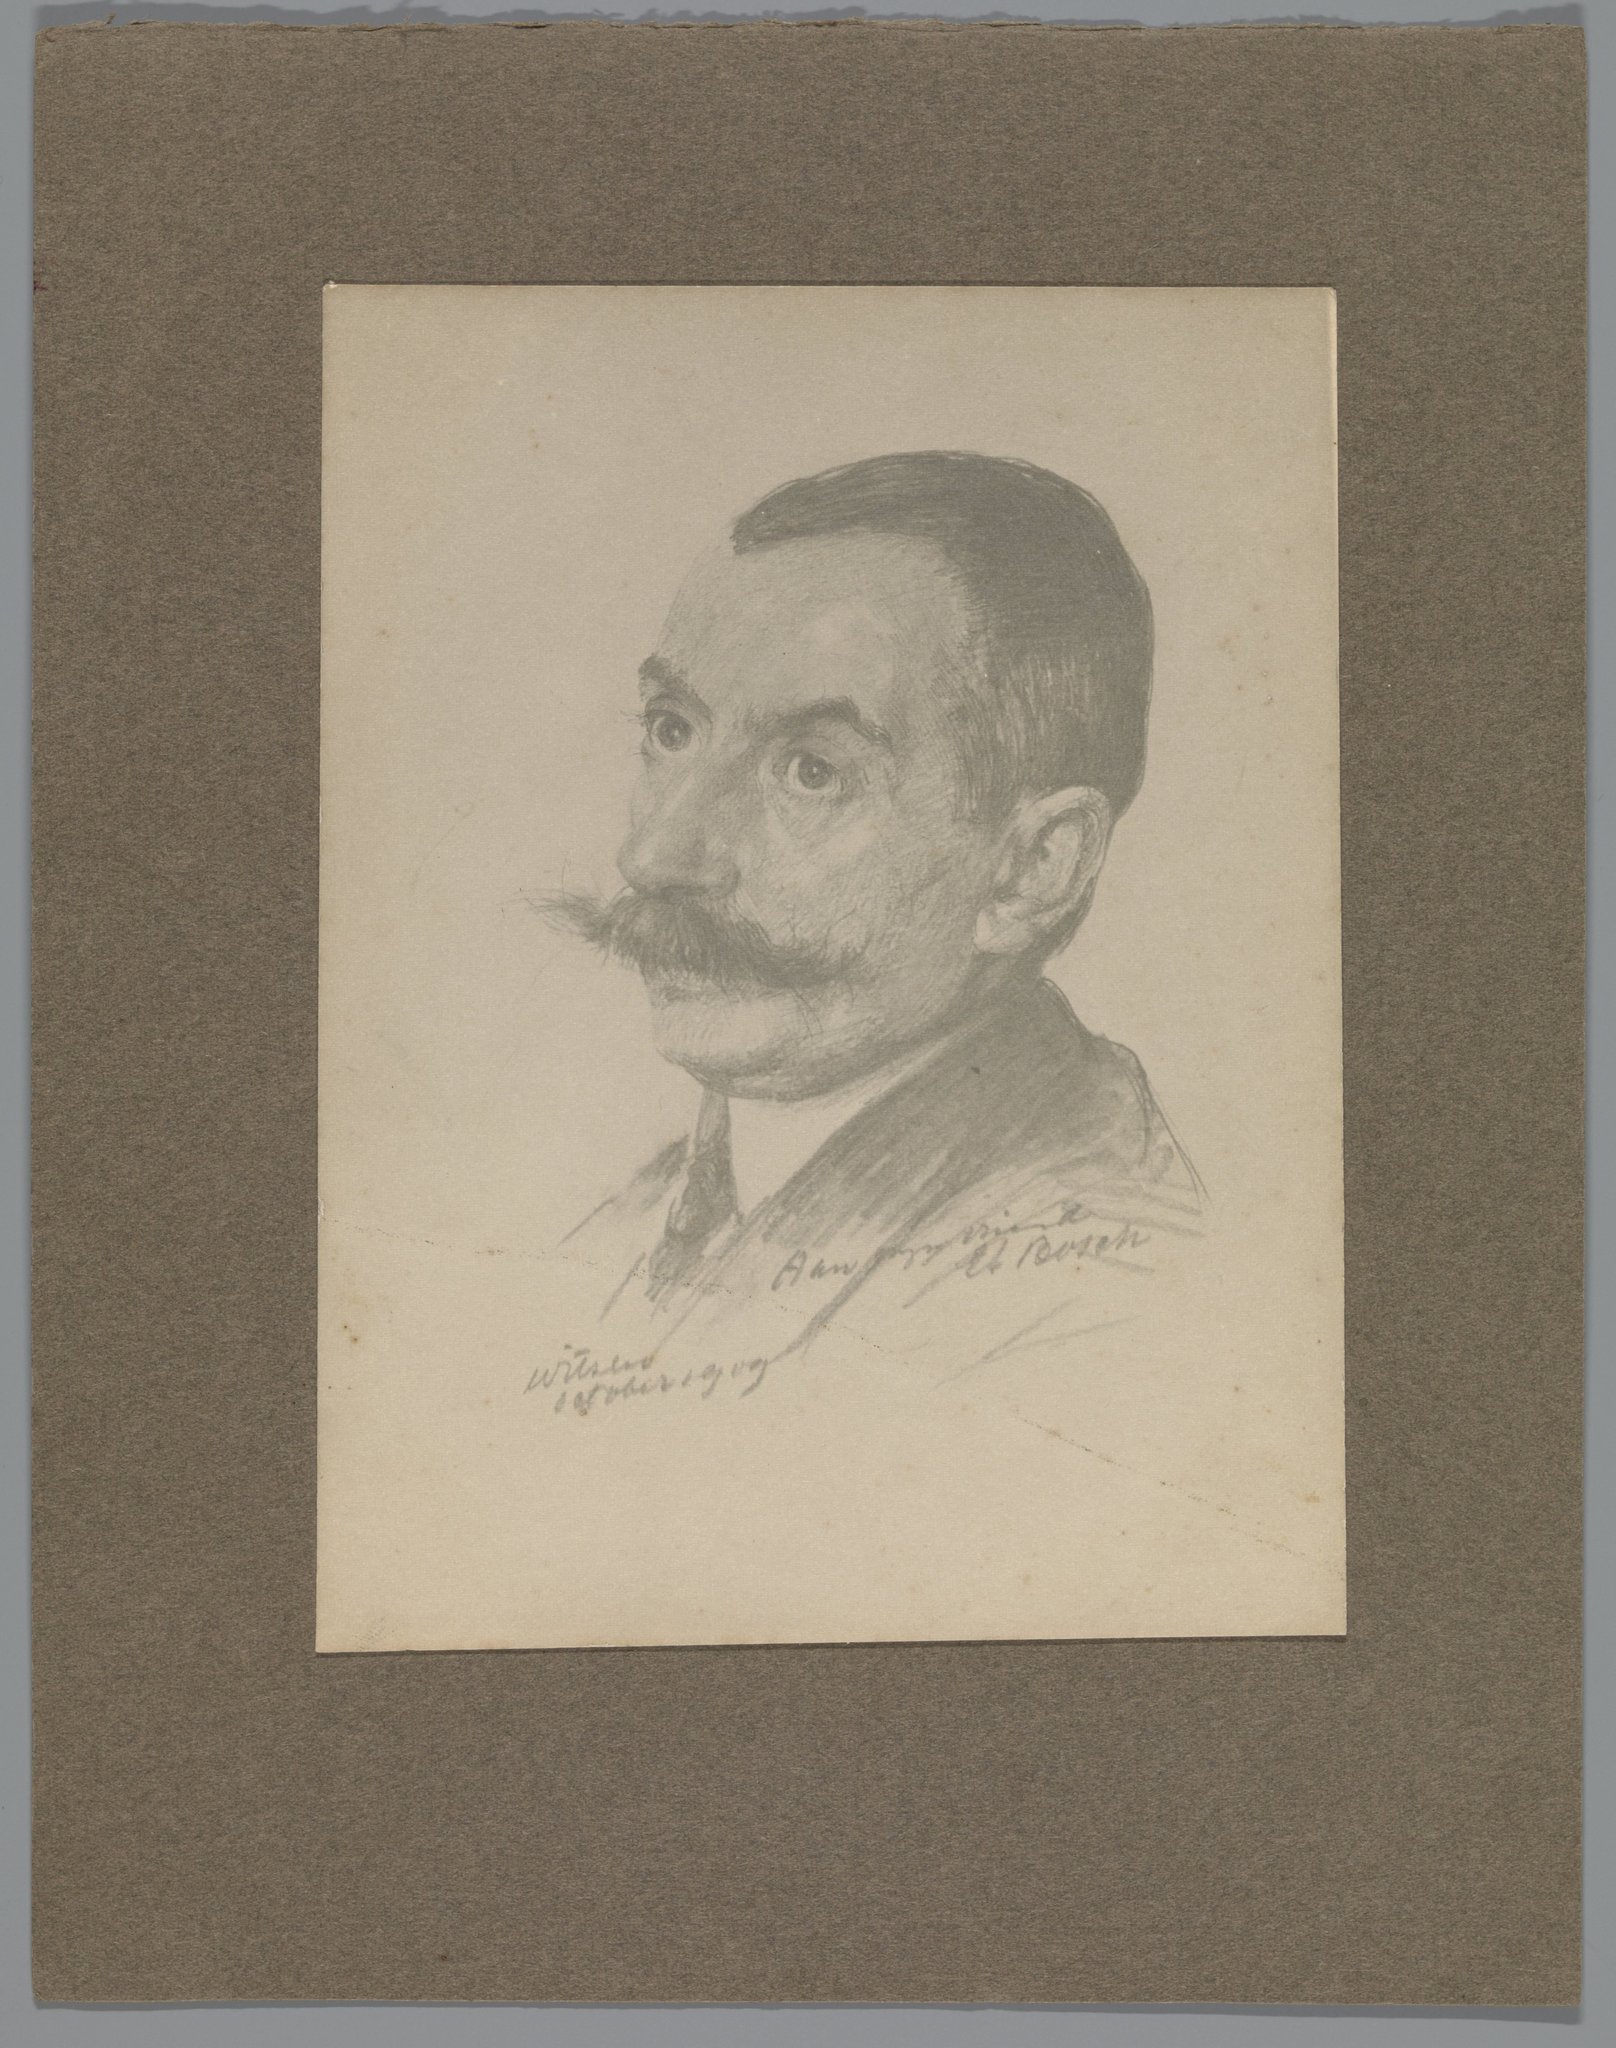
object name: photograph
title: Reproductie naar een foto, schilderij, tekening of prent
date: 1860-1915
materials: cardboard, paper, photographic support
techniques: gelatin silver print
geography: netherlands